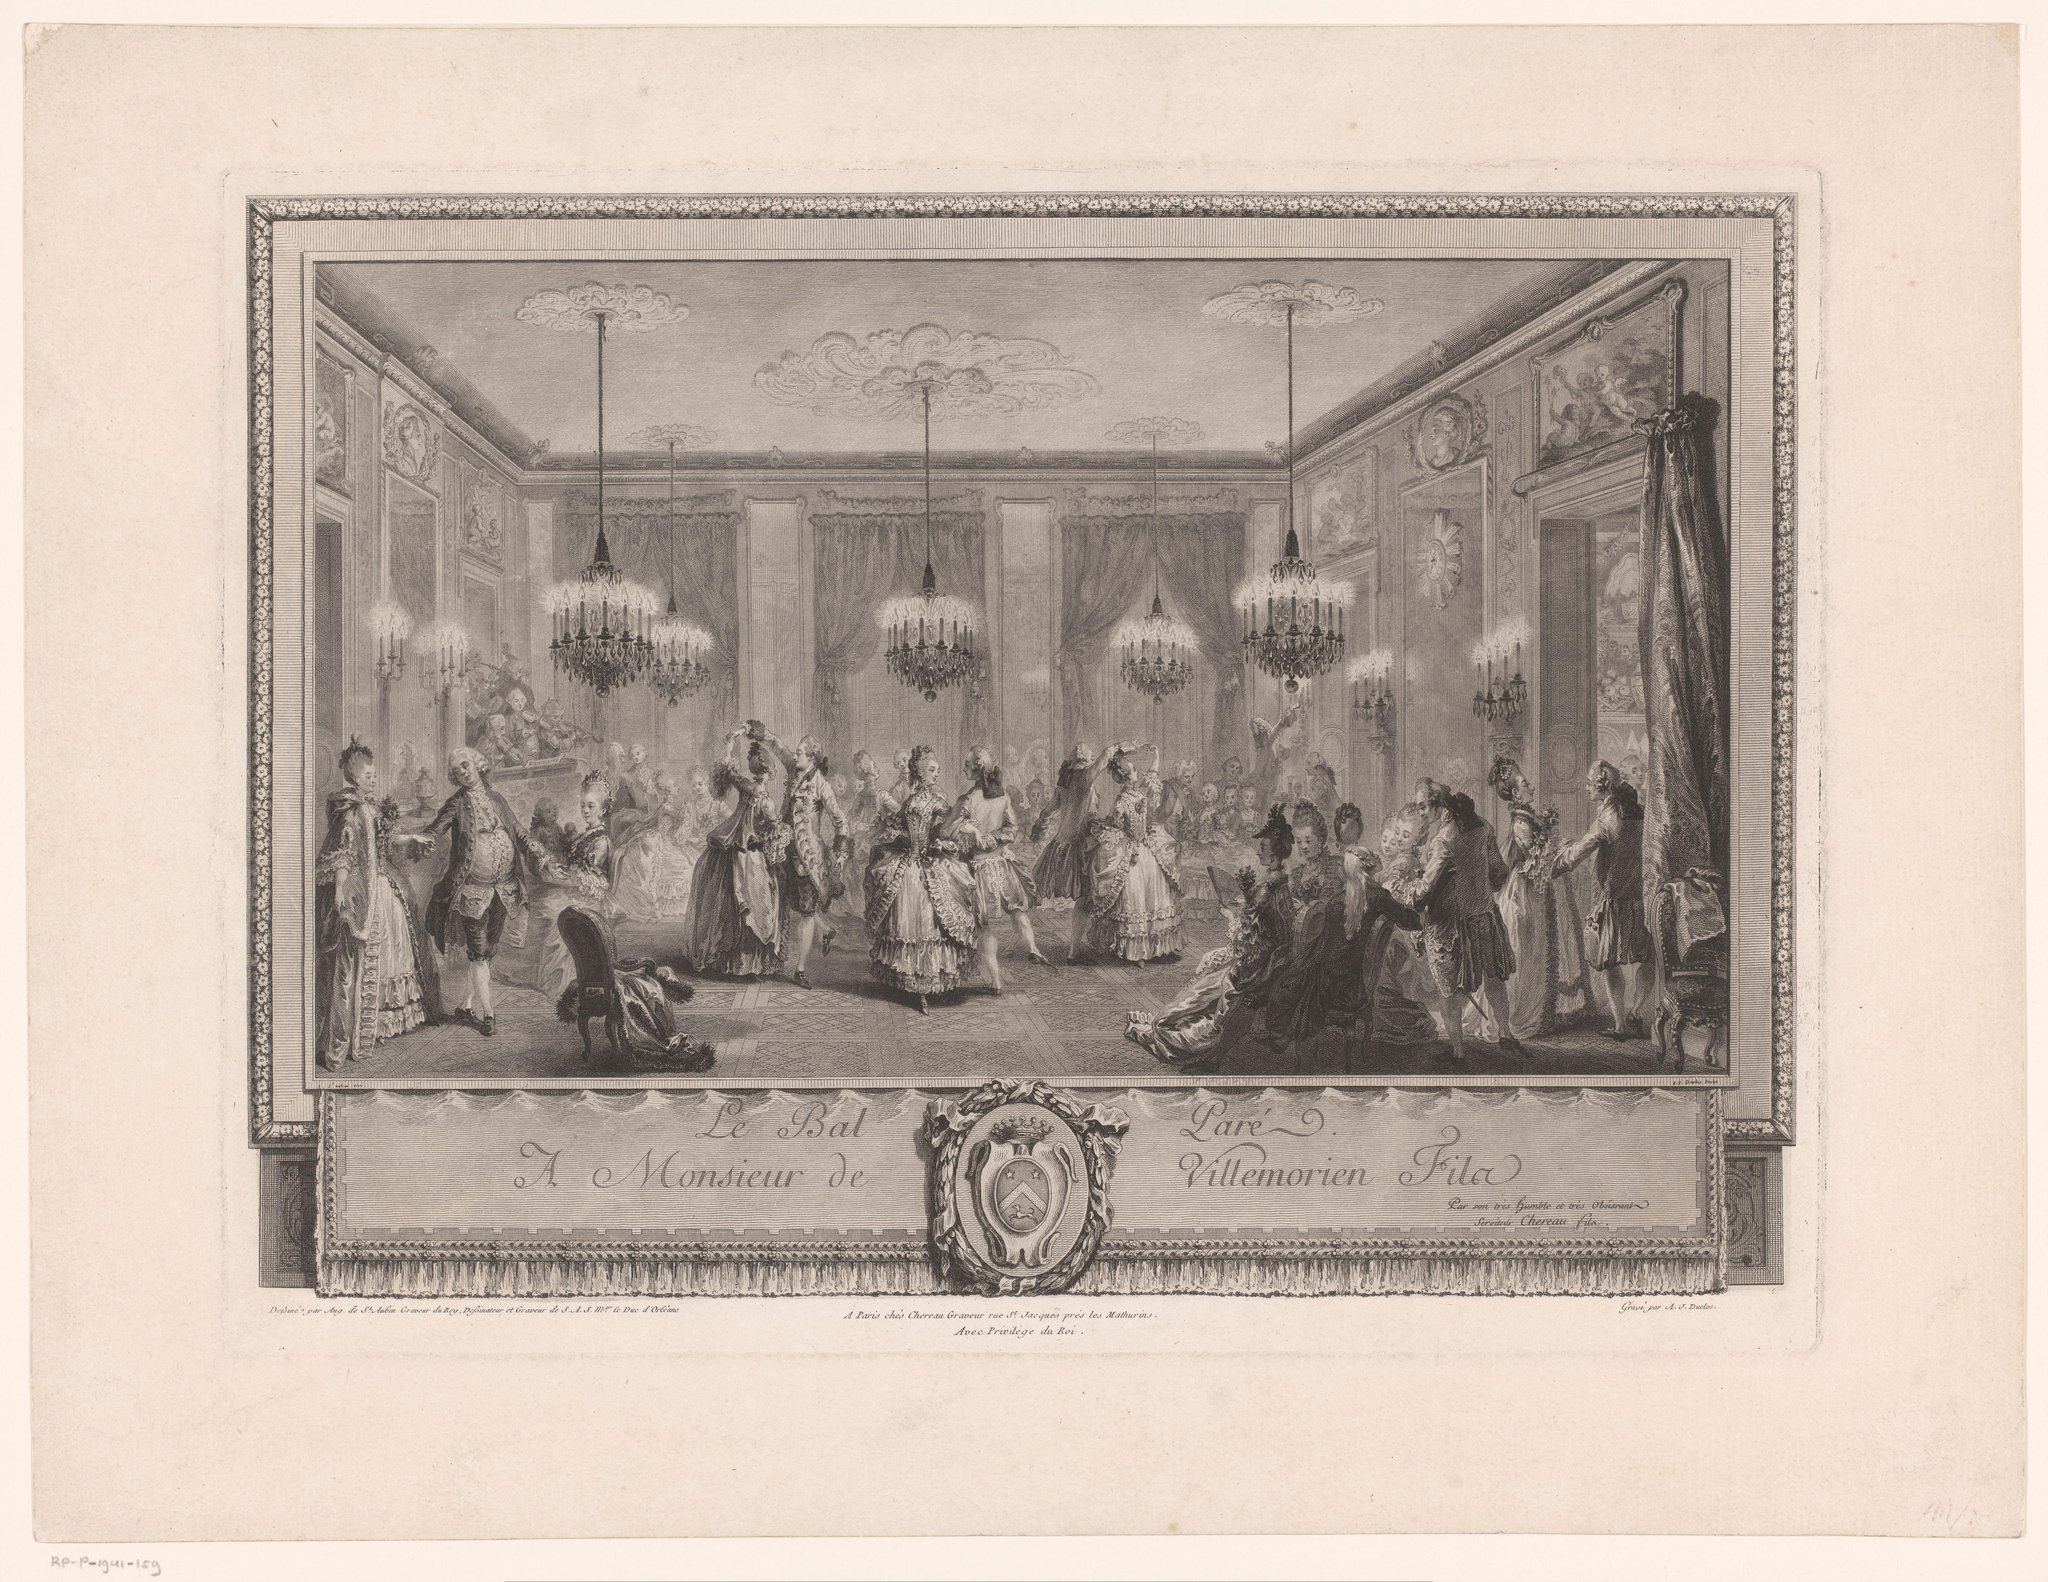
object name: costume print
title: Marie Antoinette: The Queen of Fashion: Ball at the Home of Monsieur de Villemorien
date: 1774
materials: paper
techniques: engraving, etching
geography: paris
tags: party clothes, festive attire, dress, gown: ball gown (+ women's clothes), ball, formal dance, clothes, costume (+ women's clothes), clothes, costume (+ men's clothes)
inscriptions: watermark, collector's mark: Lugt 2228, collector's mark: Lugt 2760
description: French queens were expected to set an example in the realm of fashion. As the wife of Louis XVI, Marie Antoinette threw herself into this task with enthusiasm. Together with her marchande de modes Rose Bertin and her hairdresser Léonard, she launched many a new fashion. Court etiquette dictated robes de cour – lavishly embellished gowns with wide skirts. When receiving visitors, Marie Antoinette wore a robe à la polonaise 1 2, but preferred an informal, loose-fitting gown when at her own pavilion in Versailles. This chemise de la reine 3 was quickly adopted by other women of the elite.